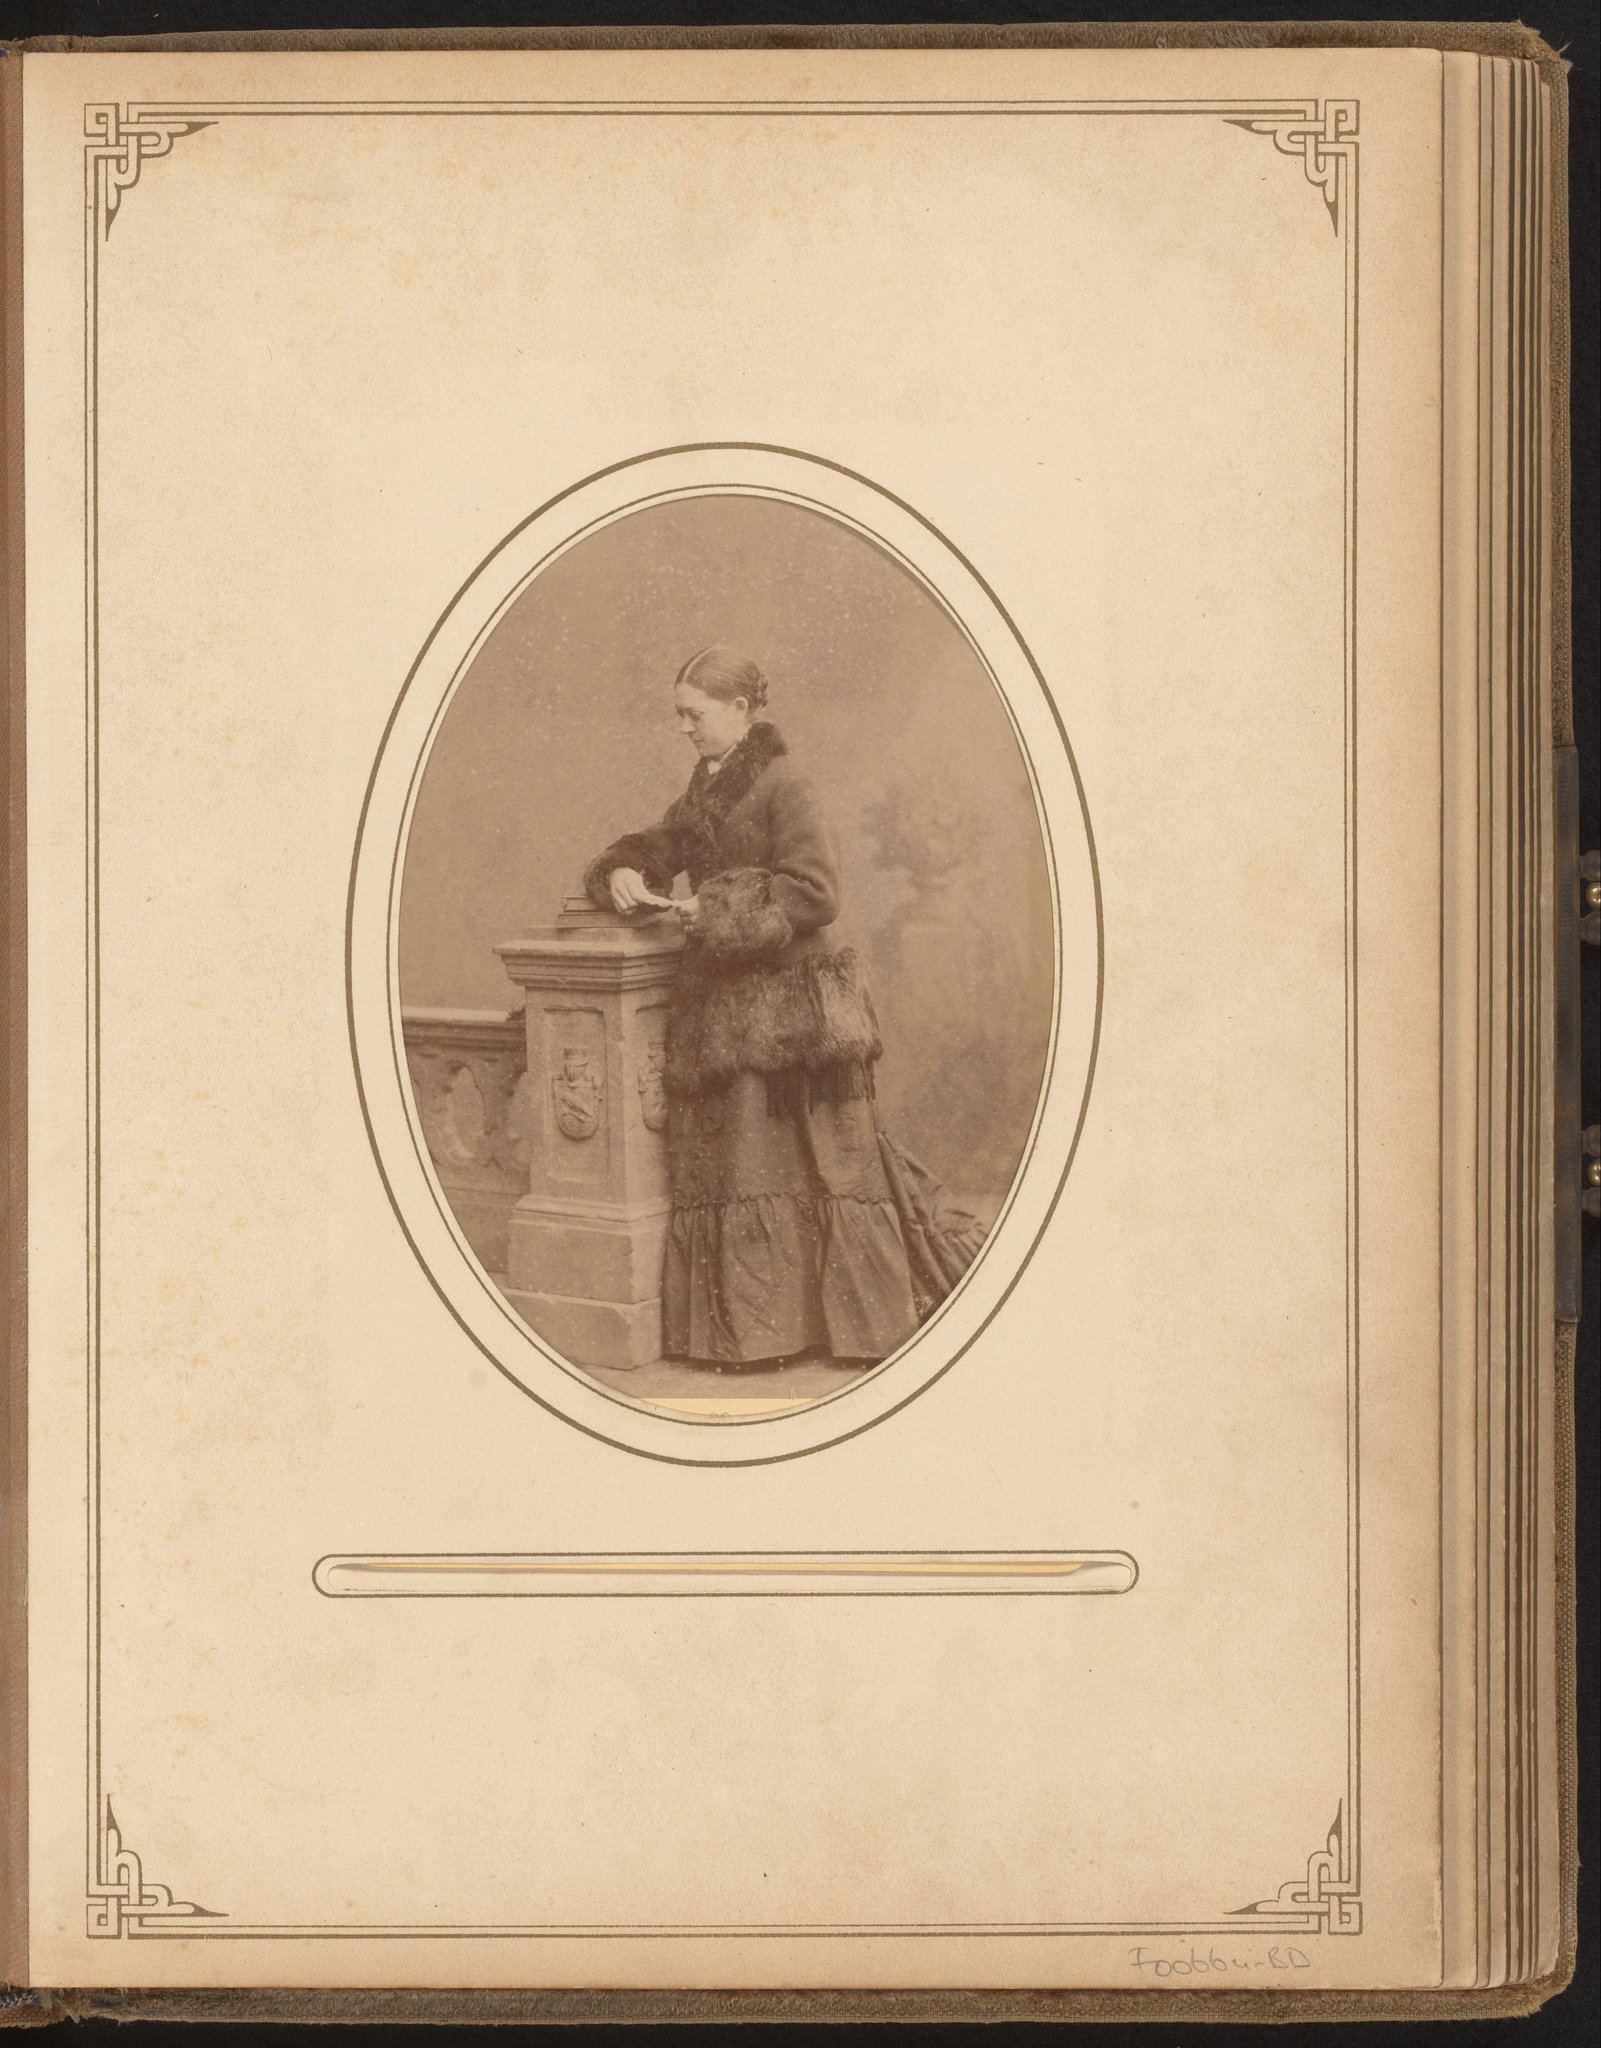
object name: cabinet photograph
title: Portret van een vrouw met bontjas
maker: carel eduard westerborg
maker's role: fotograaf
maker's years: 1842-1916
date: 1861-1880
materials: cardboard, photographic support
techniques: albumen print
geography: arnhem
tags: historical persons - bb - woman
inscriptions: inscription: ‘Photographie/ C.E. Westerborg/ Vossenstraat B66/ Arnhem’